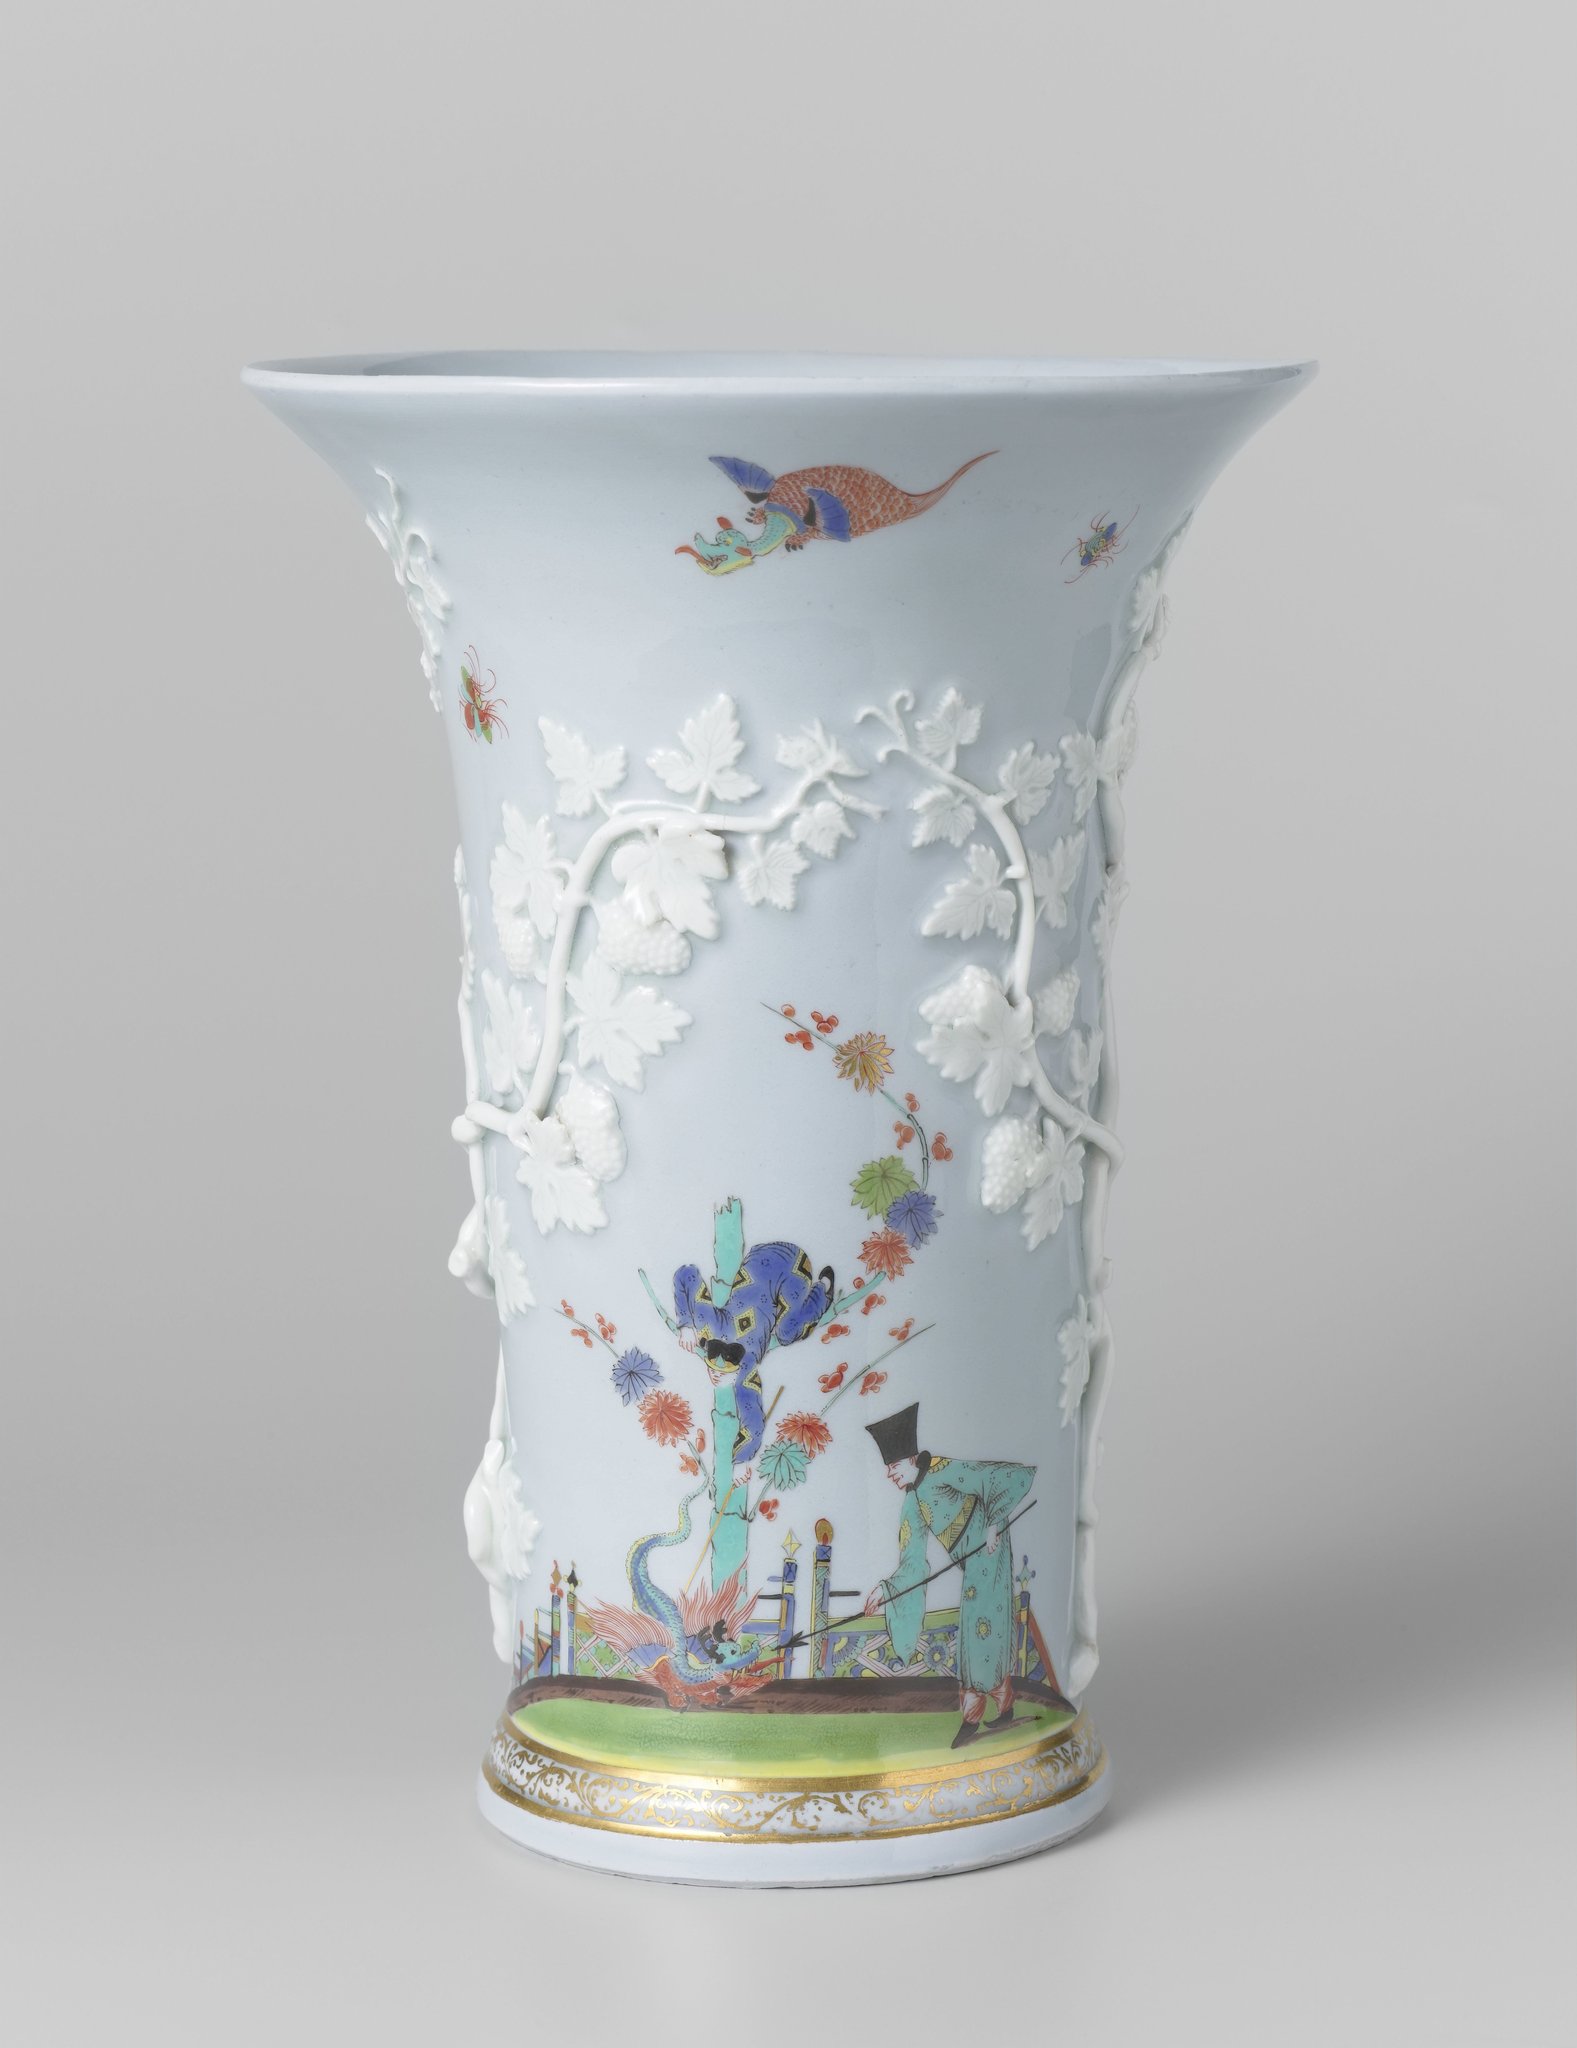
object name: vase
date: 1725-1730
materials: porcelain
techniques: painted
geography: meissen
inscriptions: number: ‘256.’, label: ‘SAMMLUNG / Dr. FRANZ OPPENHEIMER’, factory mark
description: Meissener Porzellan Manufaktur Meissen, c. 1725–1730 hard-paste porcelain